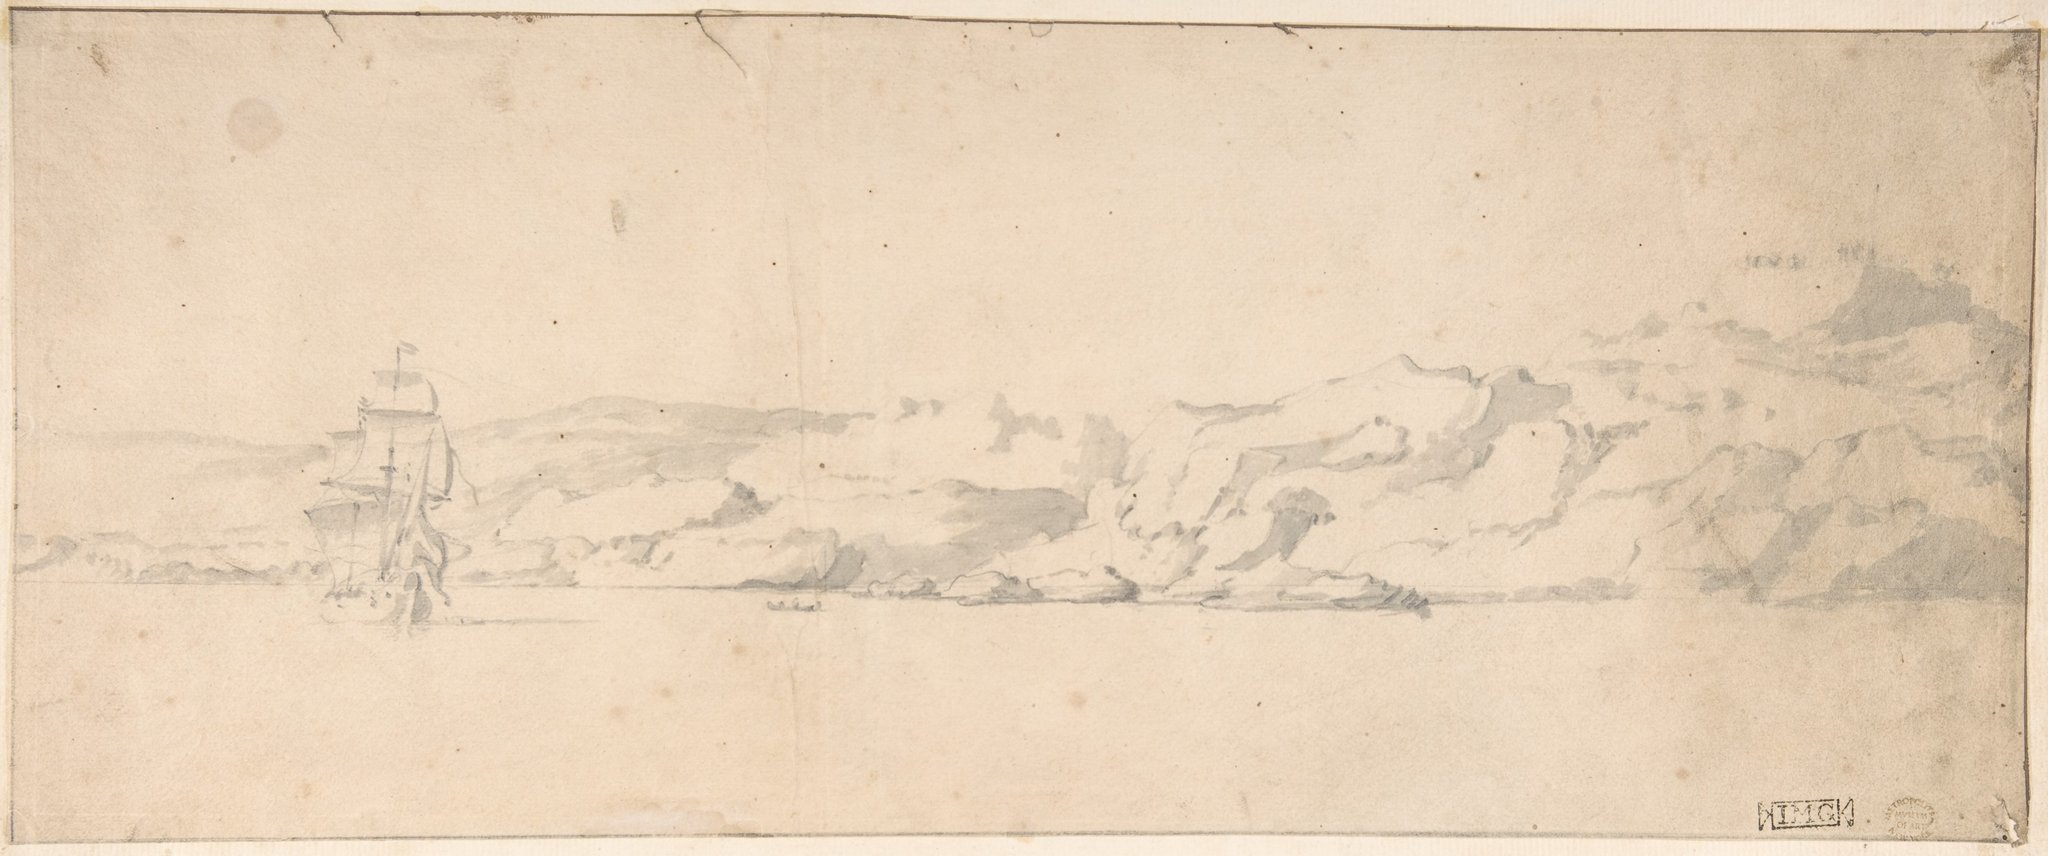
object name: drawing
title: Coast Scene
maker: willem van de velde (ii)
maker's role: artist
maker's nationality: dutch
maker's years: 1633-1707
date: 1634-1733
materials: graphite, ink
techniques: brush, pen, wash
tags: hills,ships